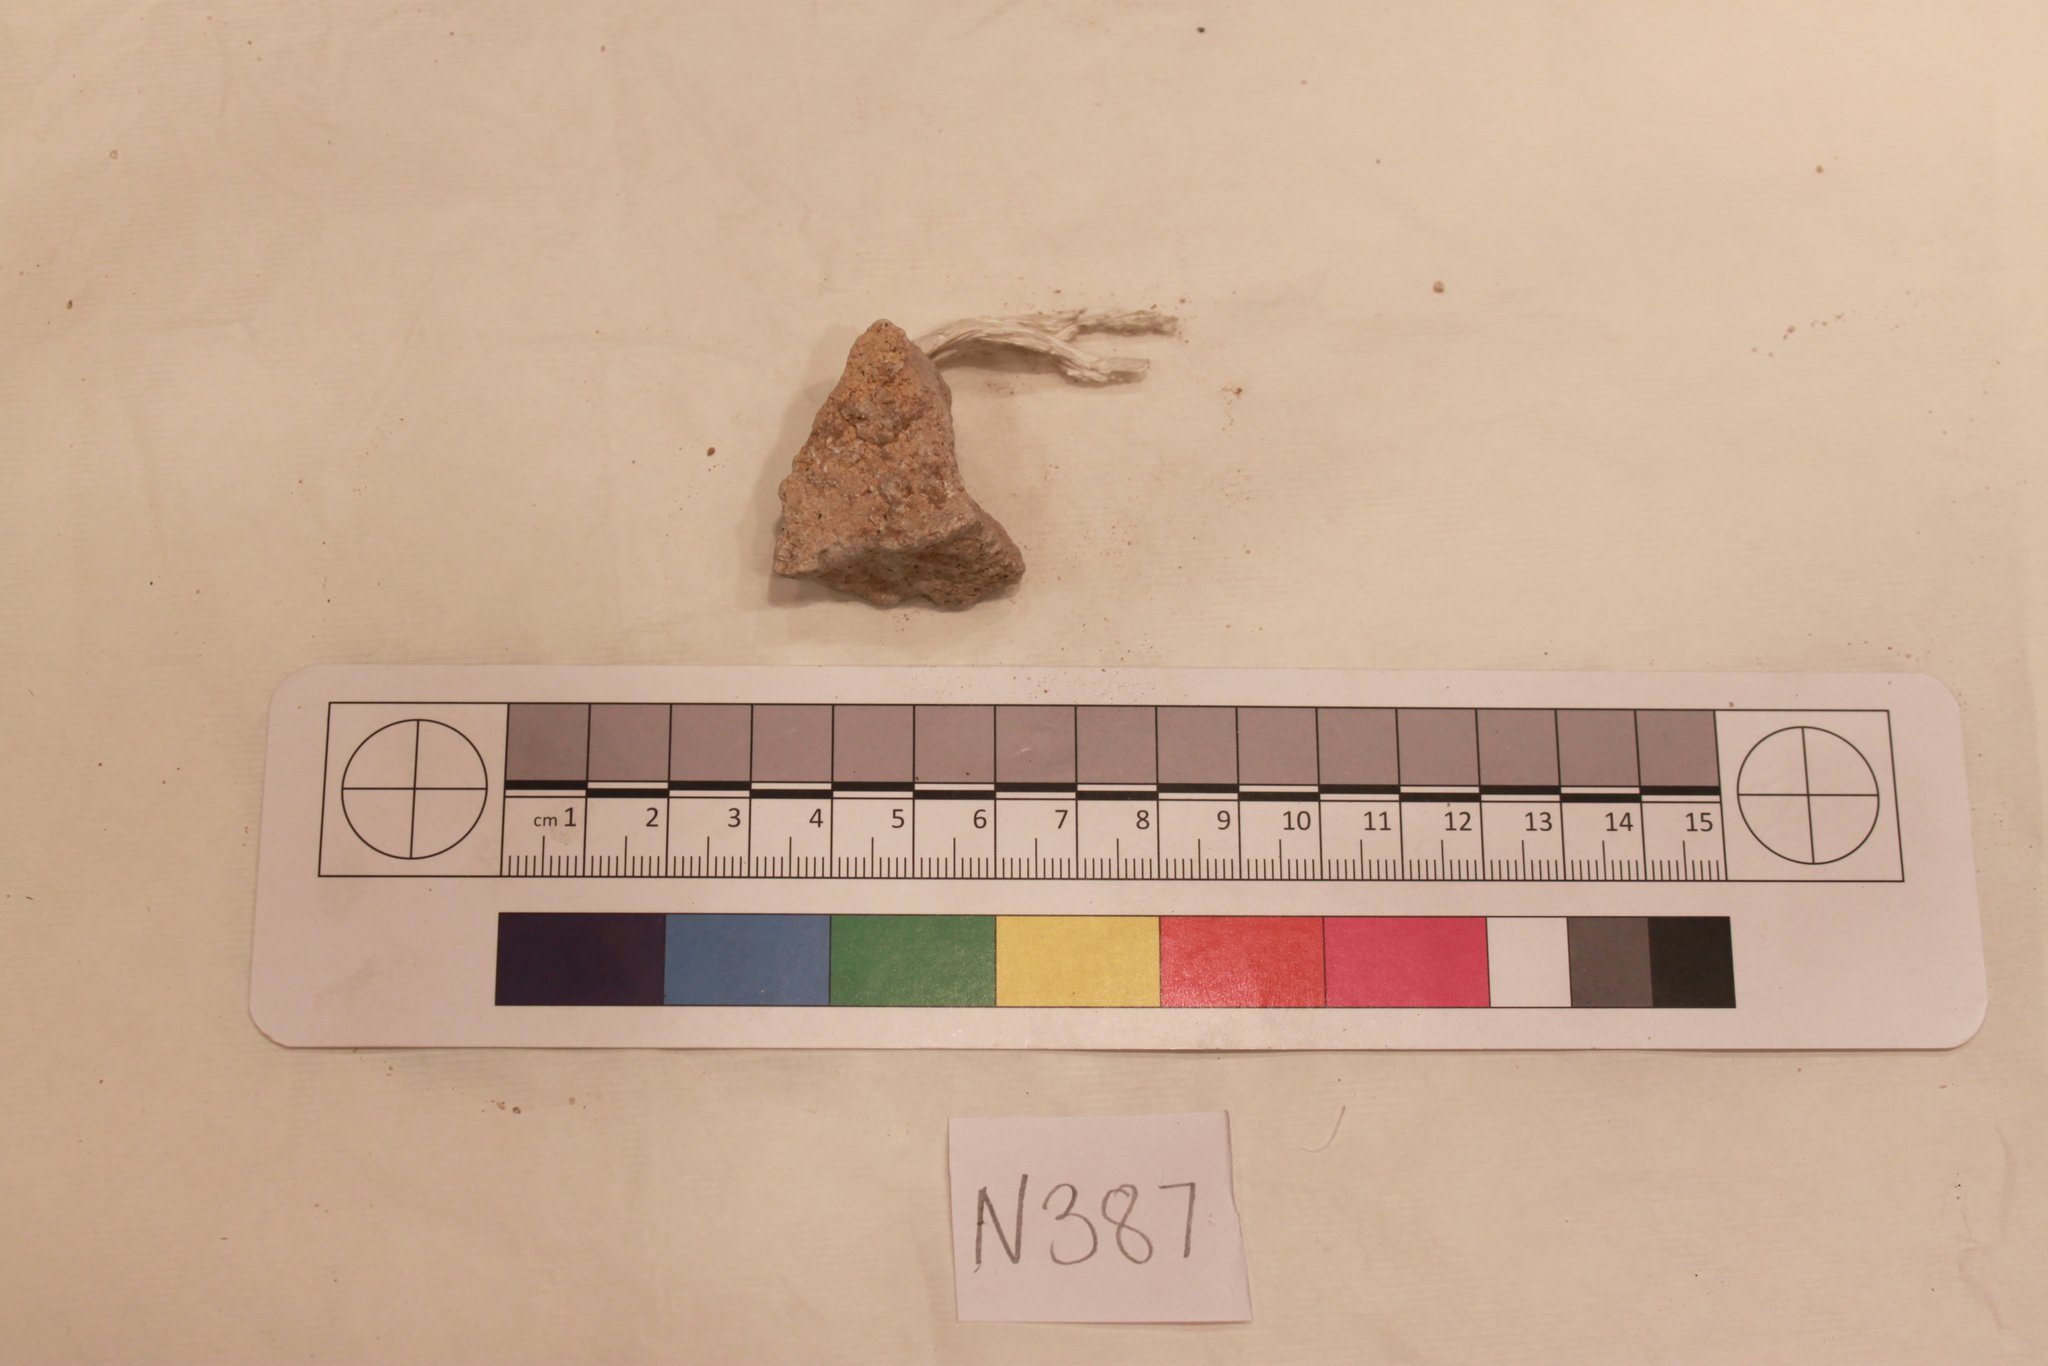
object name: fragment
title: Stucco Fragment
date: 701-1200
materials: plaster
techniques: carving, painting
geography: iran